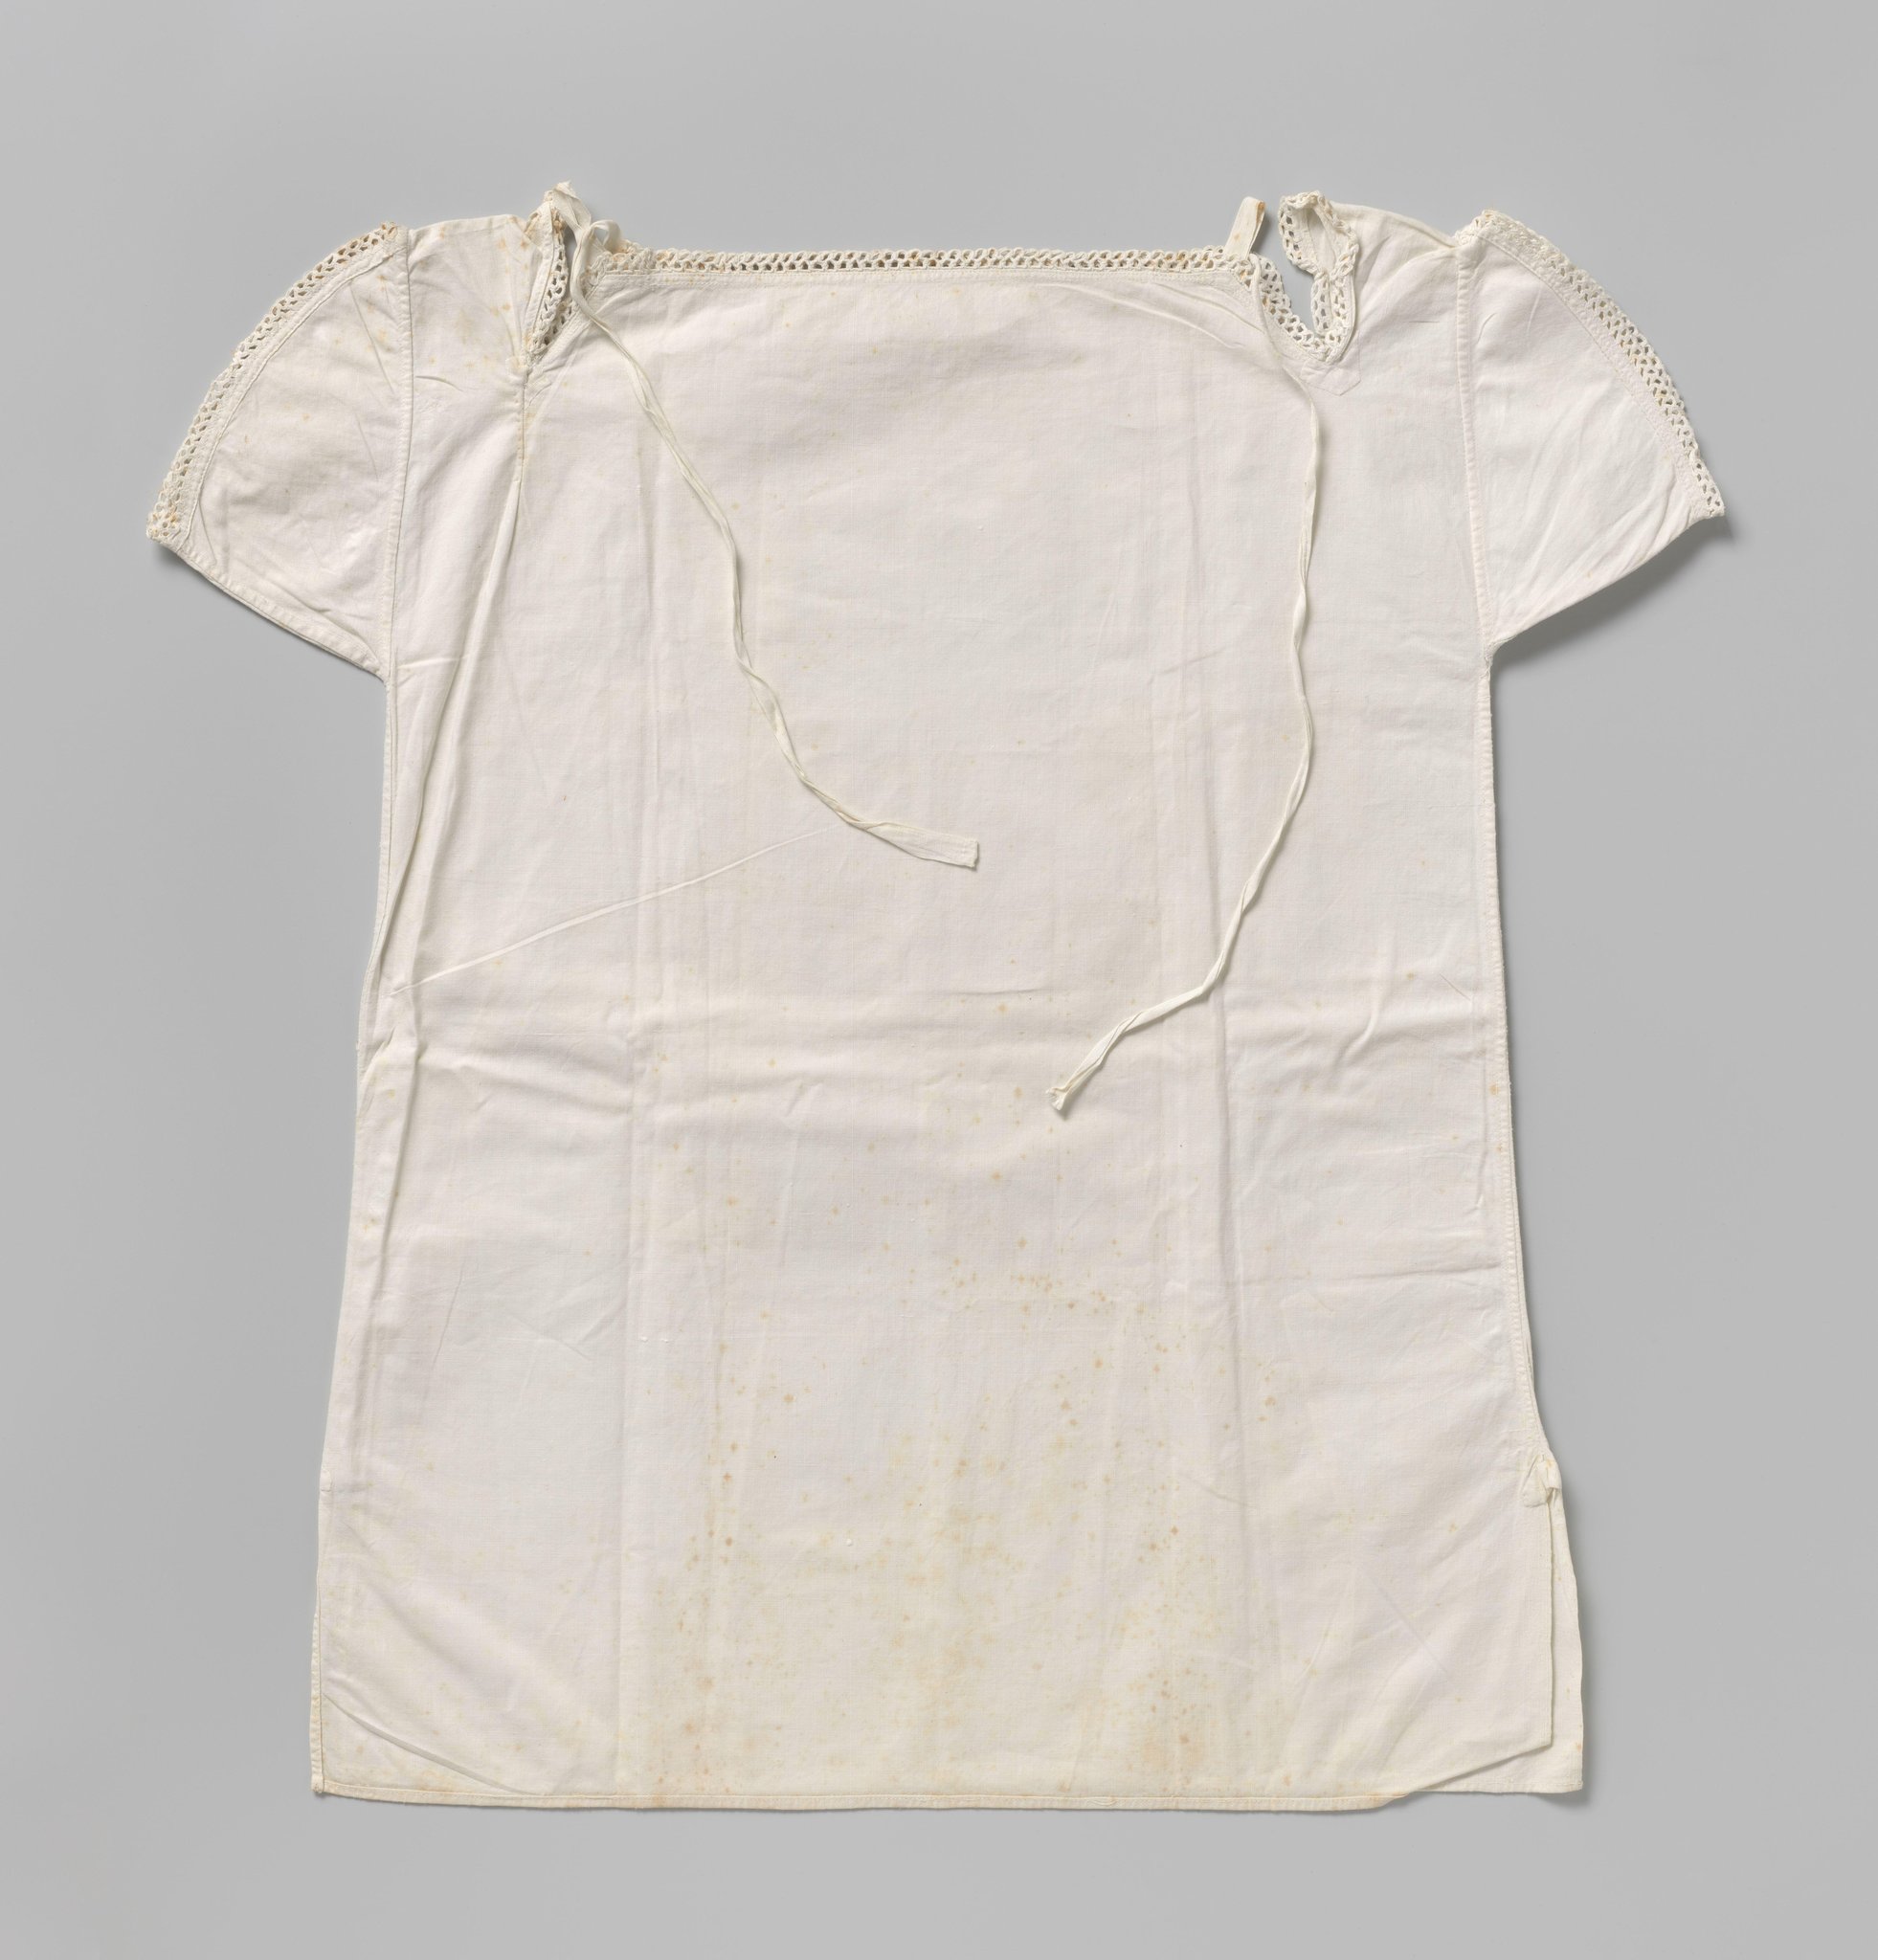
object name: nightgown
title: Kindernachtjapon van wit katoen, langs de korte mouw en hals afgezet met een opengewerkte rand; gemerkt in roze kruissteek: DCM9.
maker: Anonymous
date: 1890-1900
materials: cotton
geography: netherlands